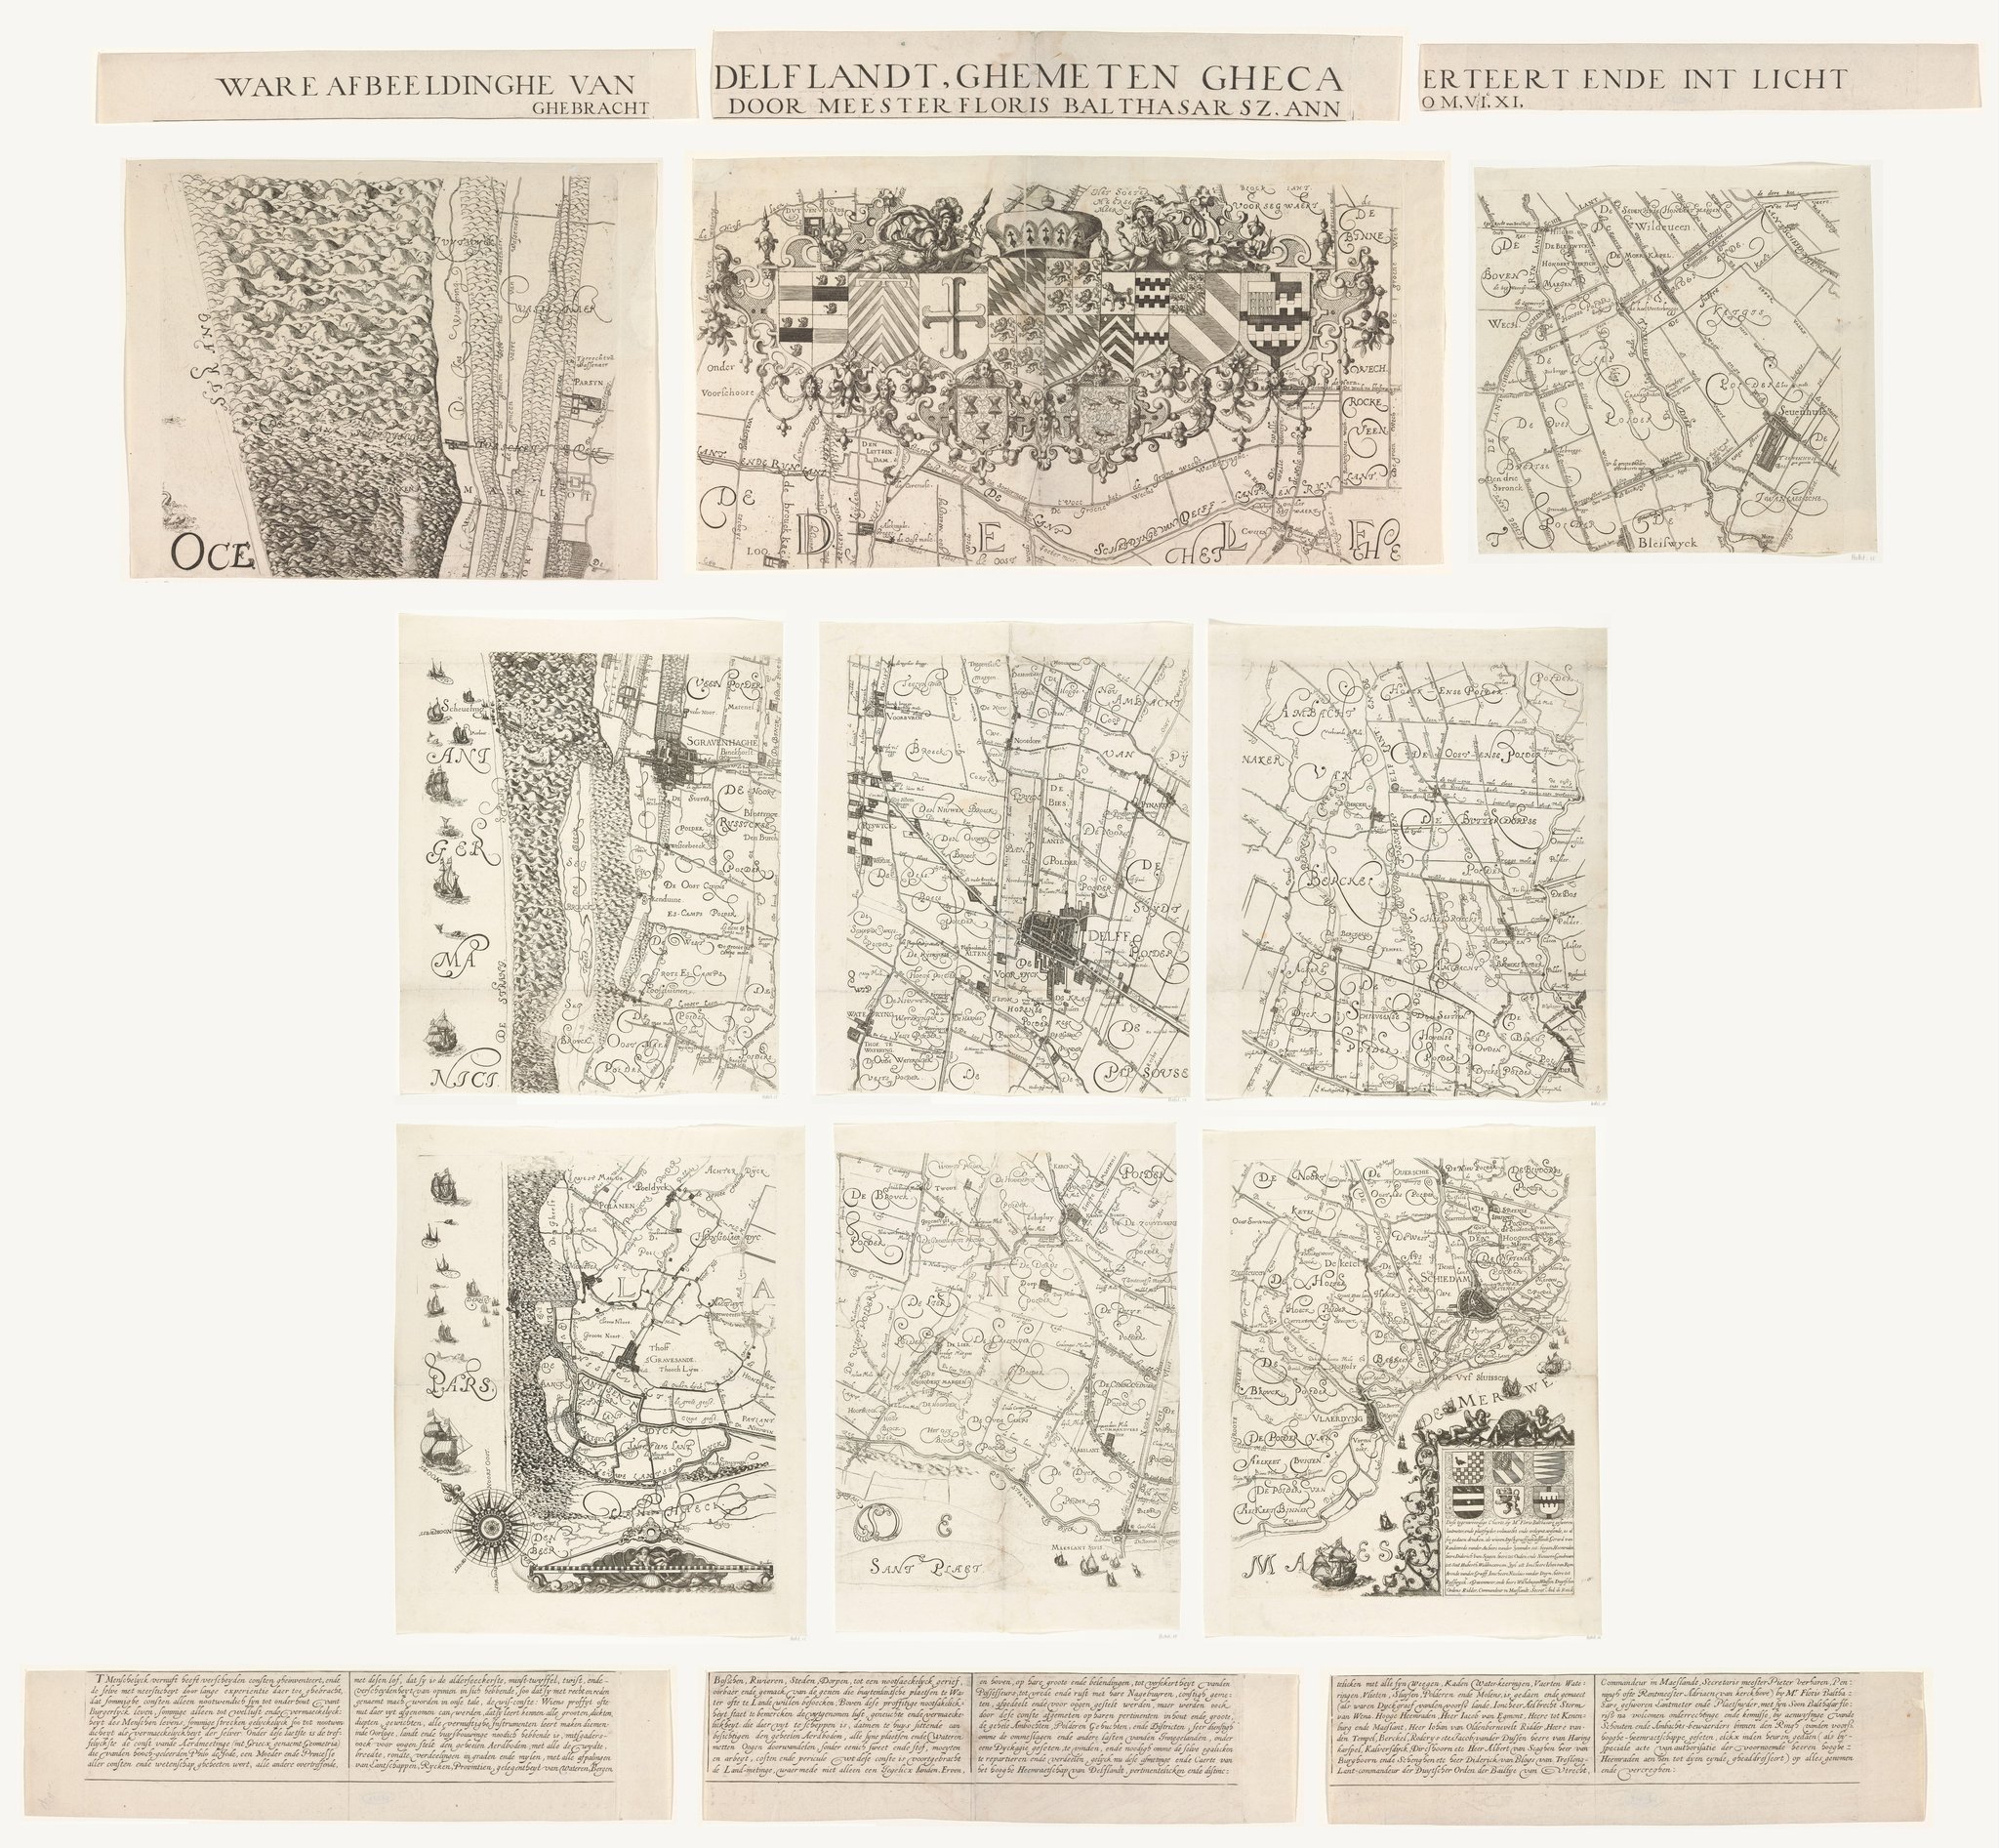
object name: print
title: Kaart van Delfland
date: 1612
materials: paper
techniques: engraving, etching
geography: delft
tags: delfland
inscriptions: collector's mark: Lugt 2228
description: Kaart van Delfland. Boven in het midden het wapen van het Hoogheemraadschap Delfland en de gemeentewapens van de steden. Linksonder een windroos. Geheel bestaande uit negen bladen en zes tekstbladen. Drie tekstbladen met de titel boven de kaart en drie tekstbladen met uitleg in zes kolommen, onder de kaart.